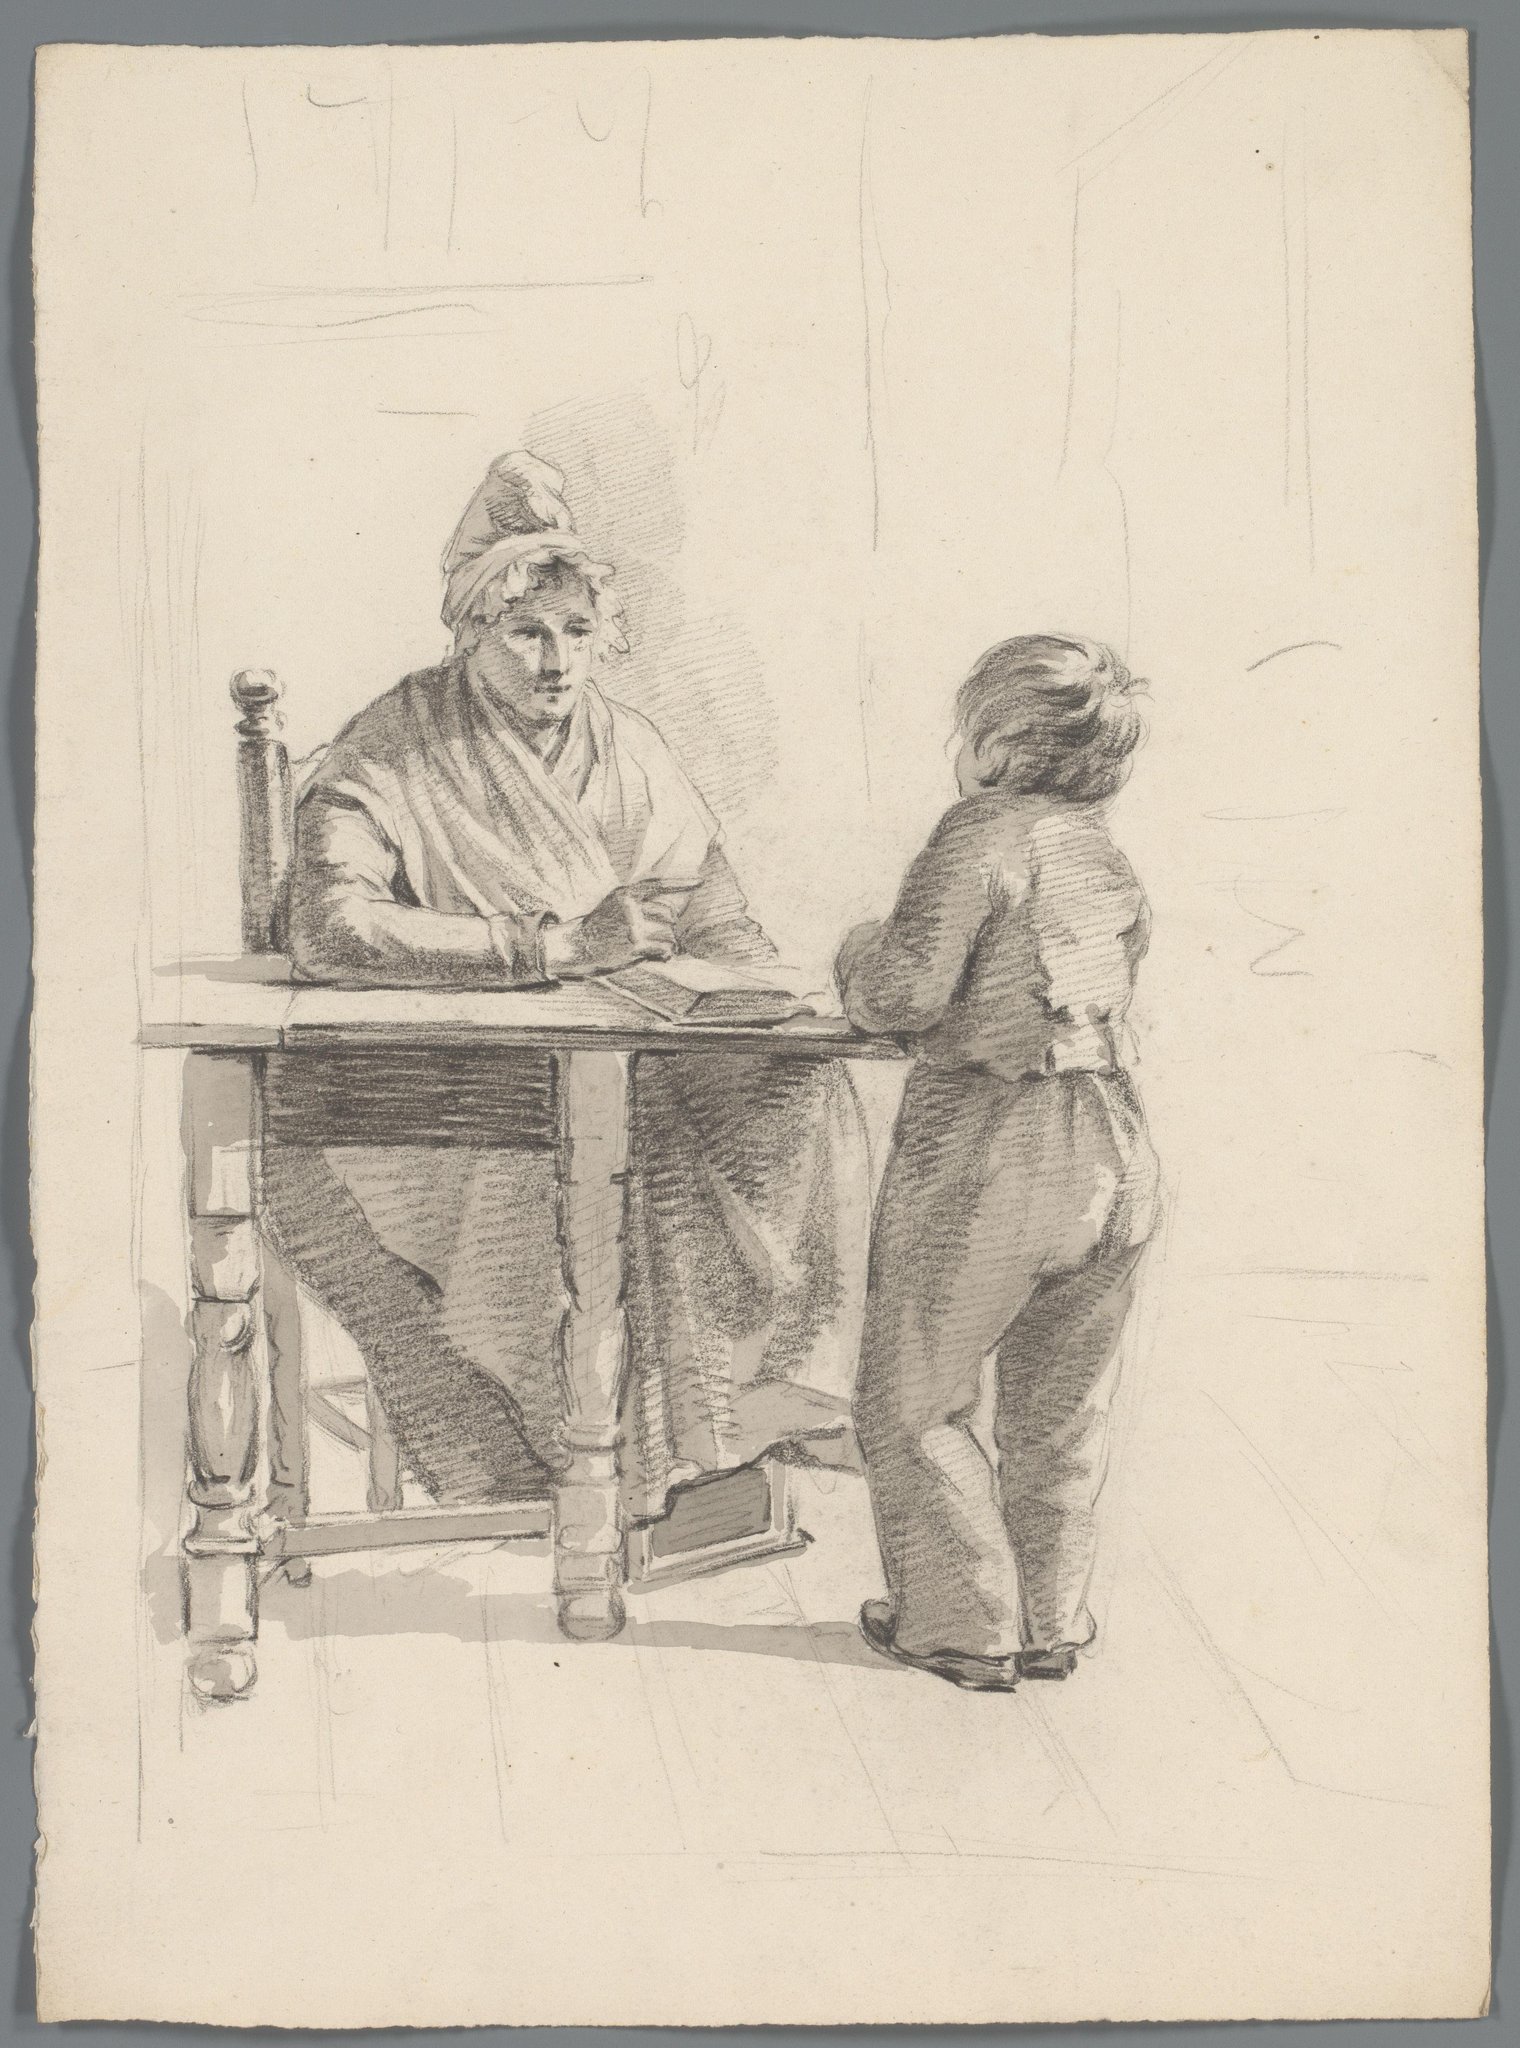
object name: drawing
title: Vrouw aan een tafel met een boek en een kind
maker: Anonymous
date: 1820-1830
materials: chalk, paper, watercolor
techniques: brush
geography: the hague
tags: adult woman, book, child (at home)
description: Tekeningen waarschijnlijk ontstaan bij het Haagse kunstgenootschap ‘Tot Nut der Tekenkunst’, waar twee keer per week tekenavonden werden georganiseerd met geklede modellen.